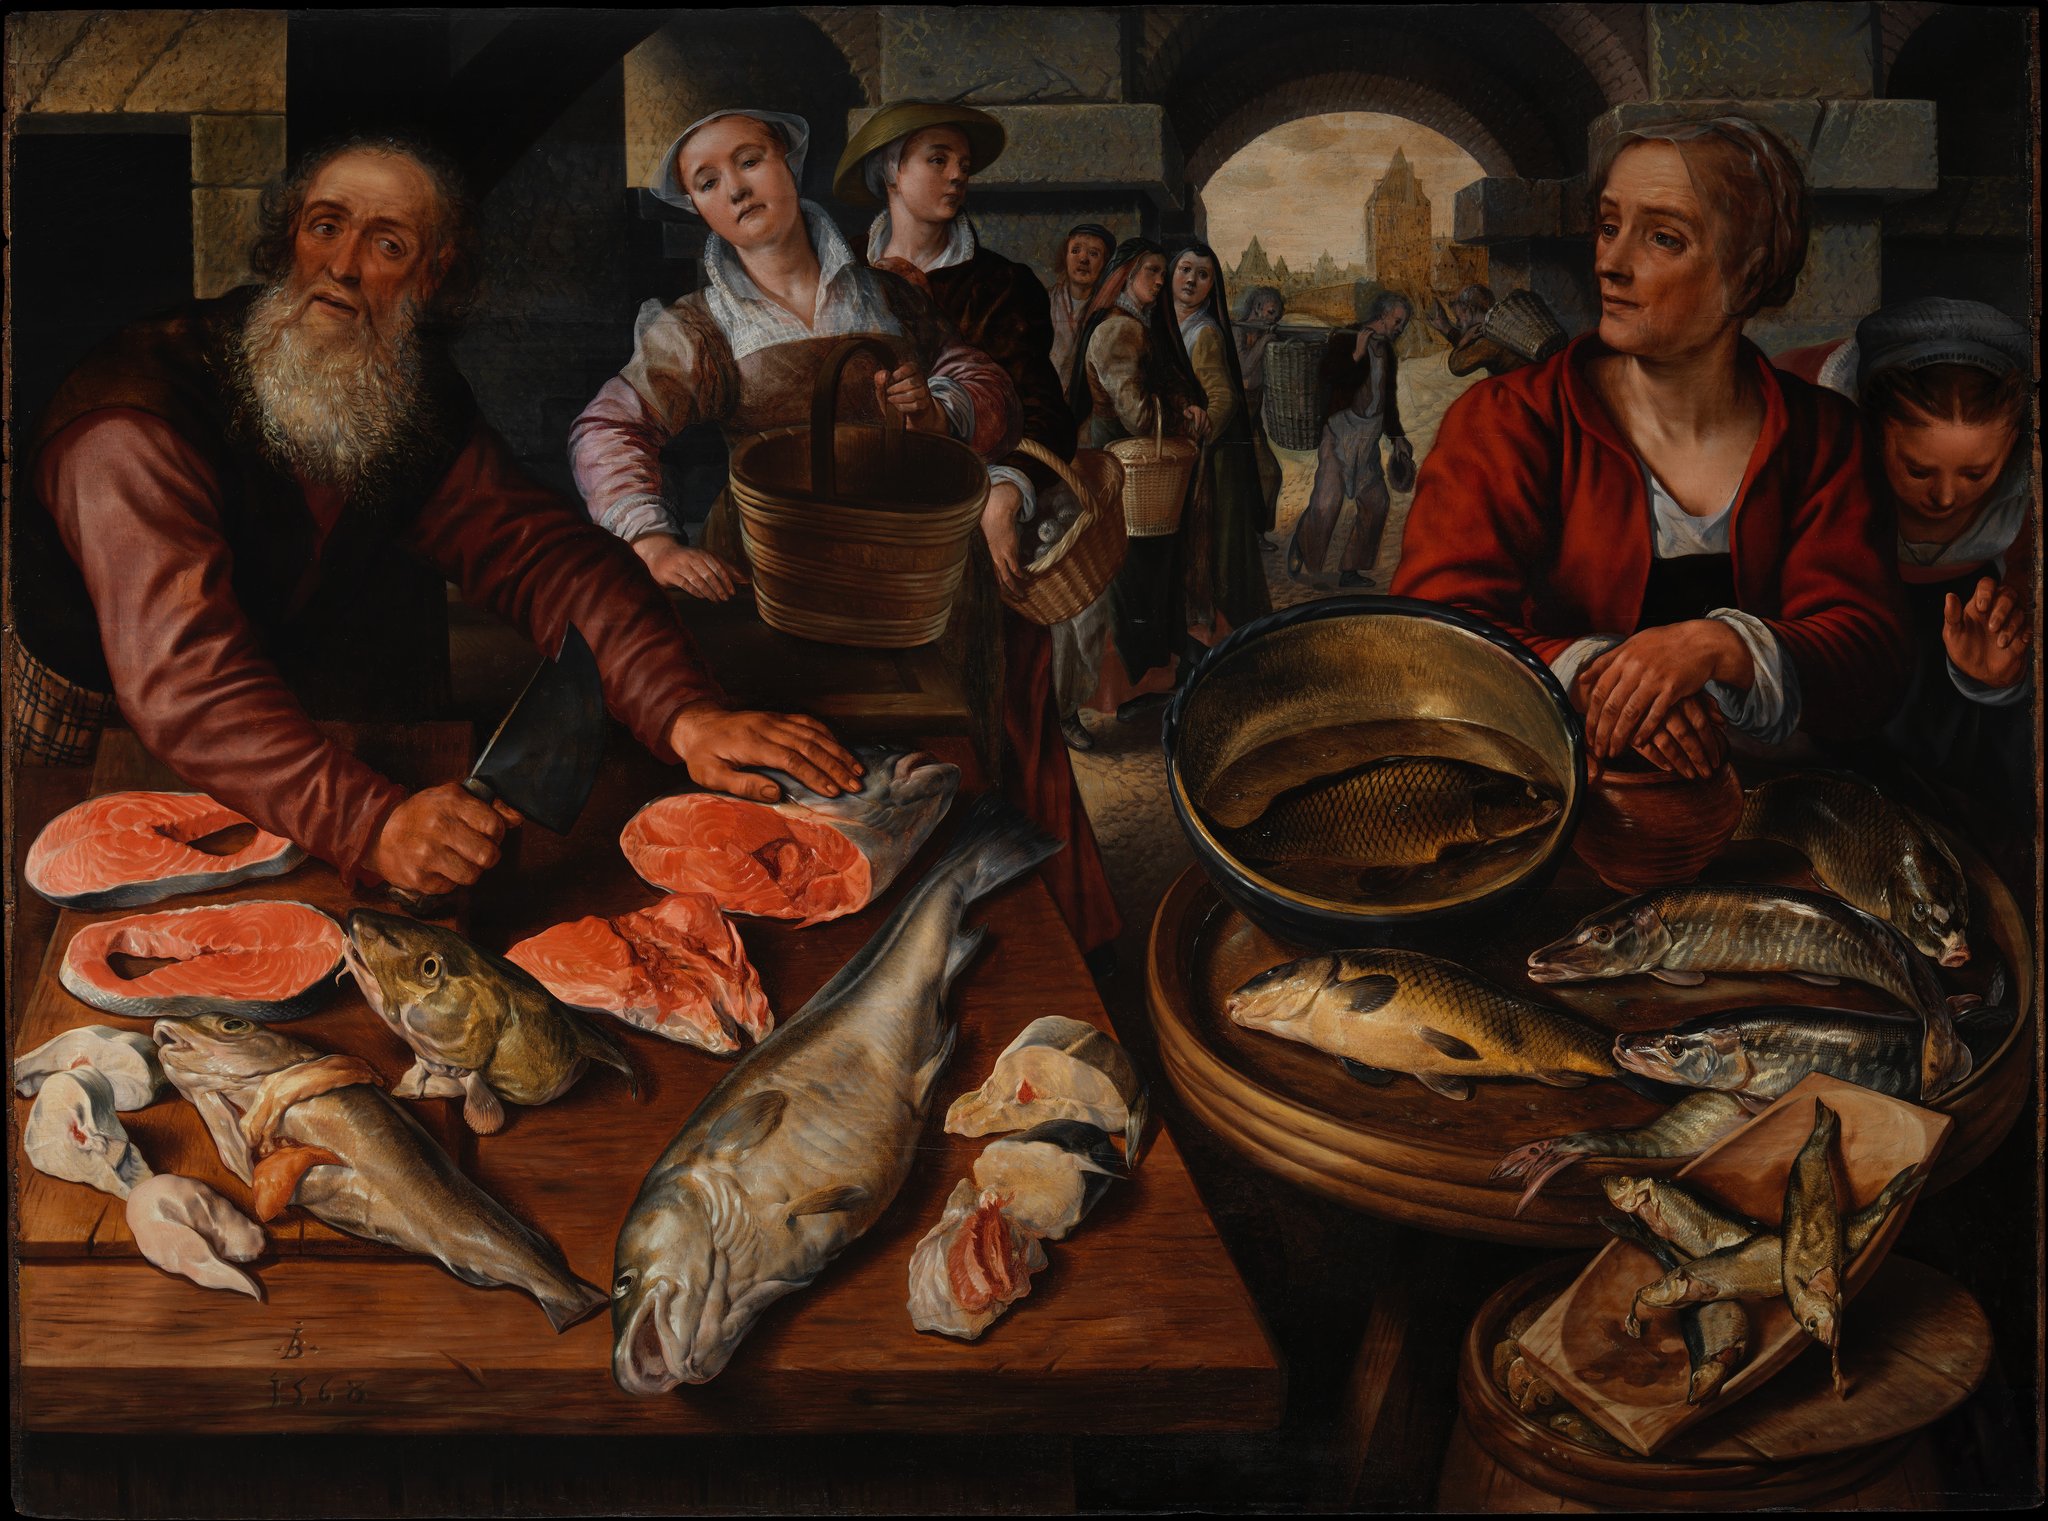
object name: painting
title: Fish Market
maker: joachim beuckelaer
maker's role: artist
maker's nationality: netherlandish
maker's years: 1533-1574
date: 1568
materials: wood, oil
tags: food,men,women,fish,markets